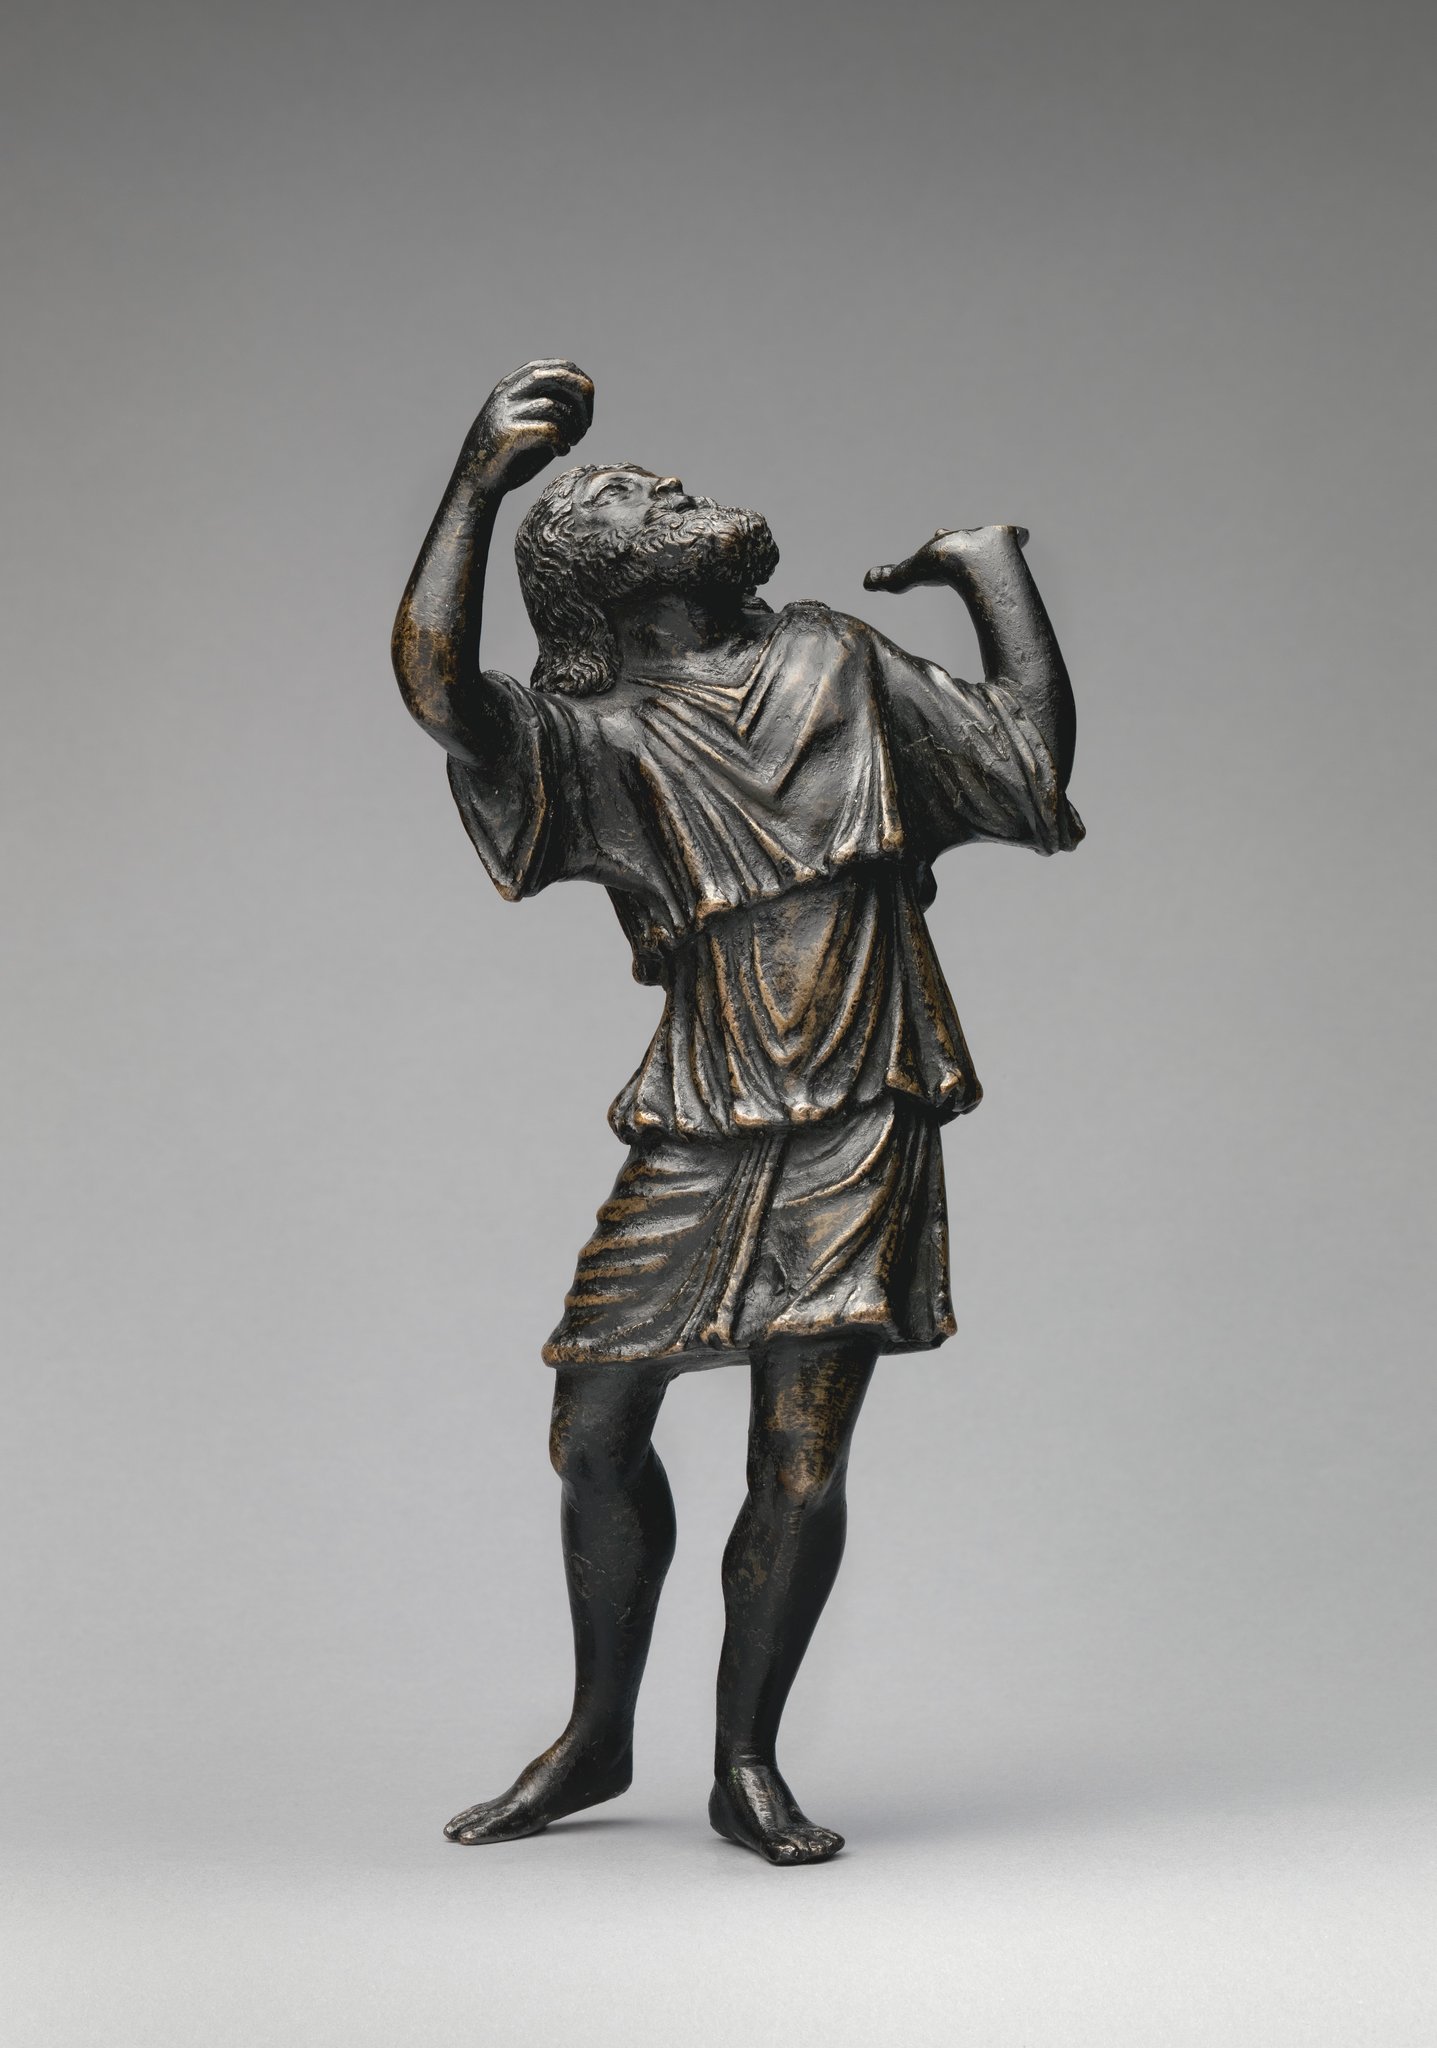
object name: statuette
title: Saint Christopher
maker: severo calzetta da ravenna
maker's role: artist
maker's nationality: italian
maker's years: 1496-1543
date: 1501-1533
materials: bronze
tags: saint christopher